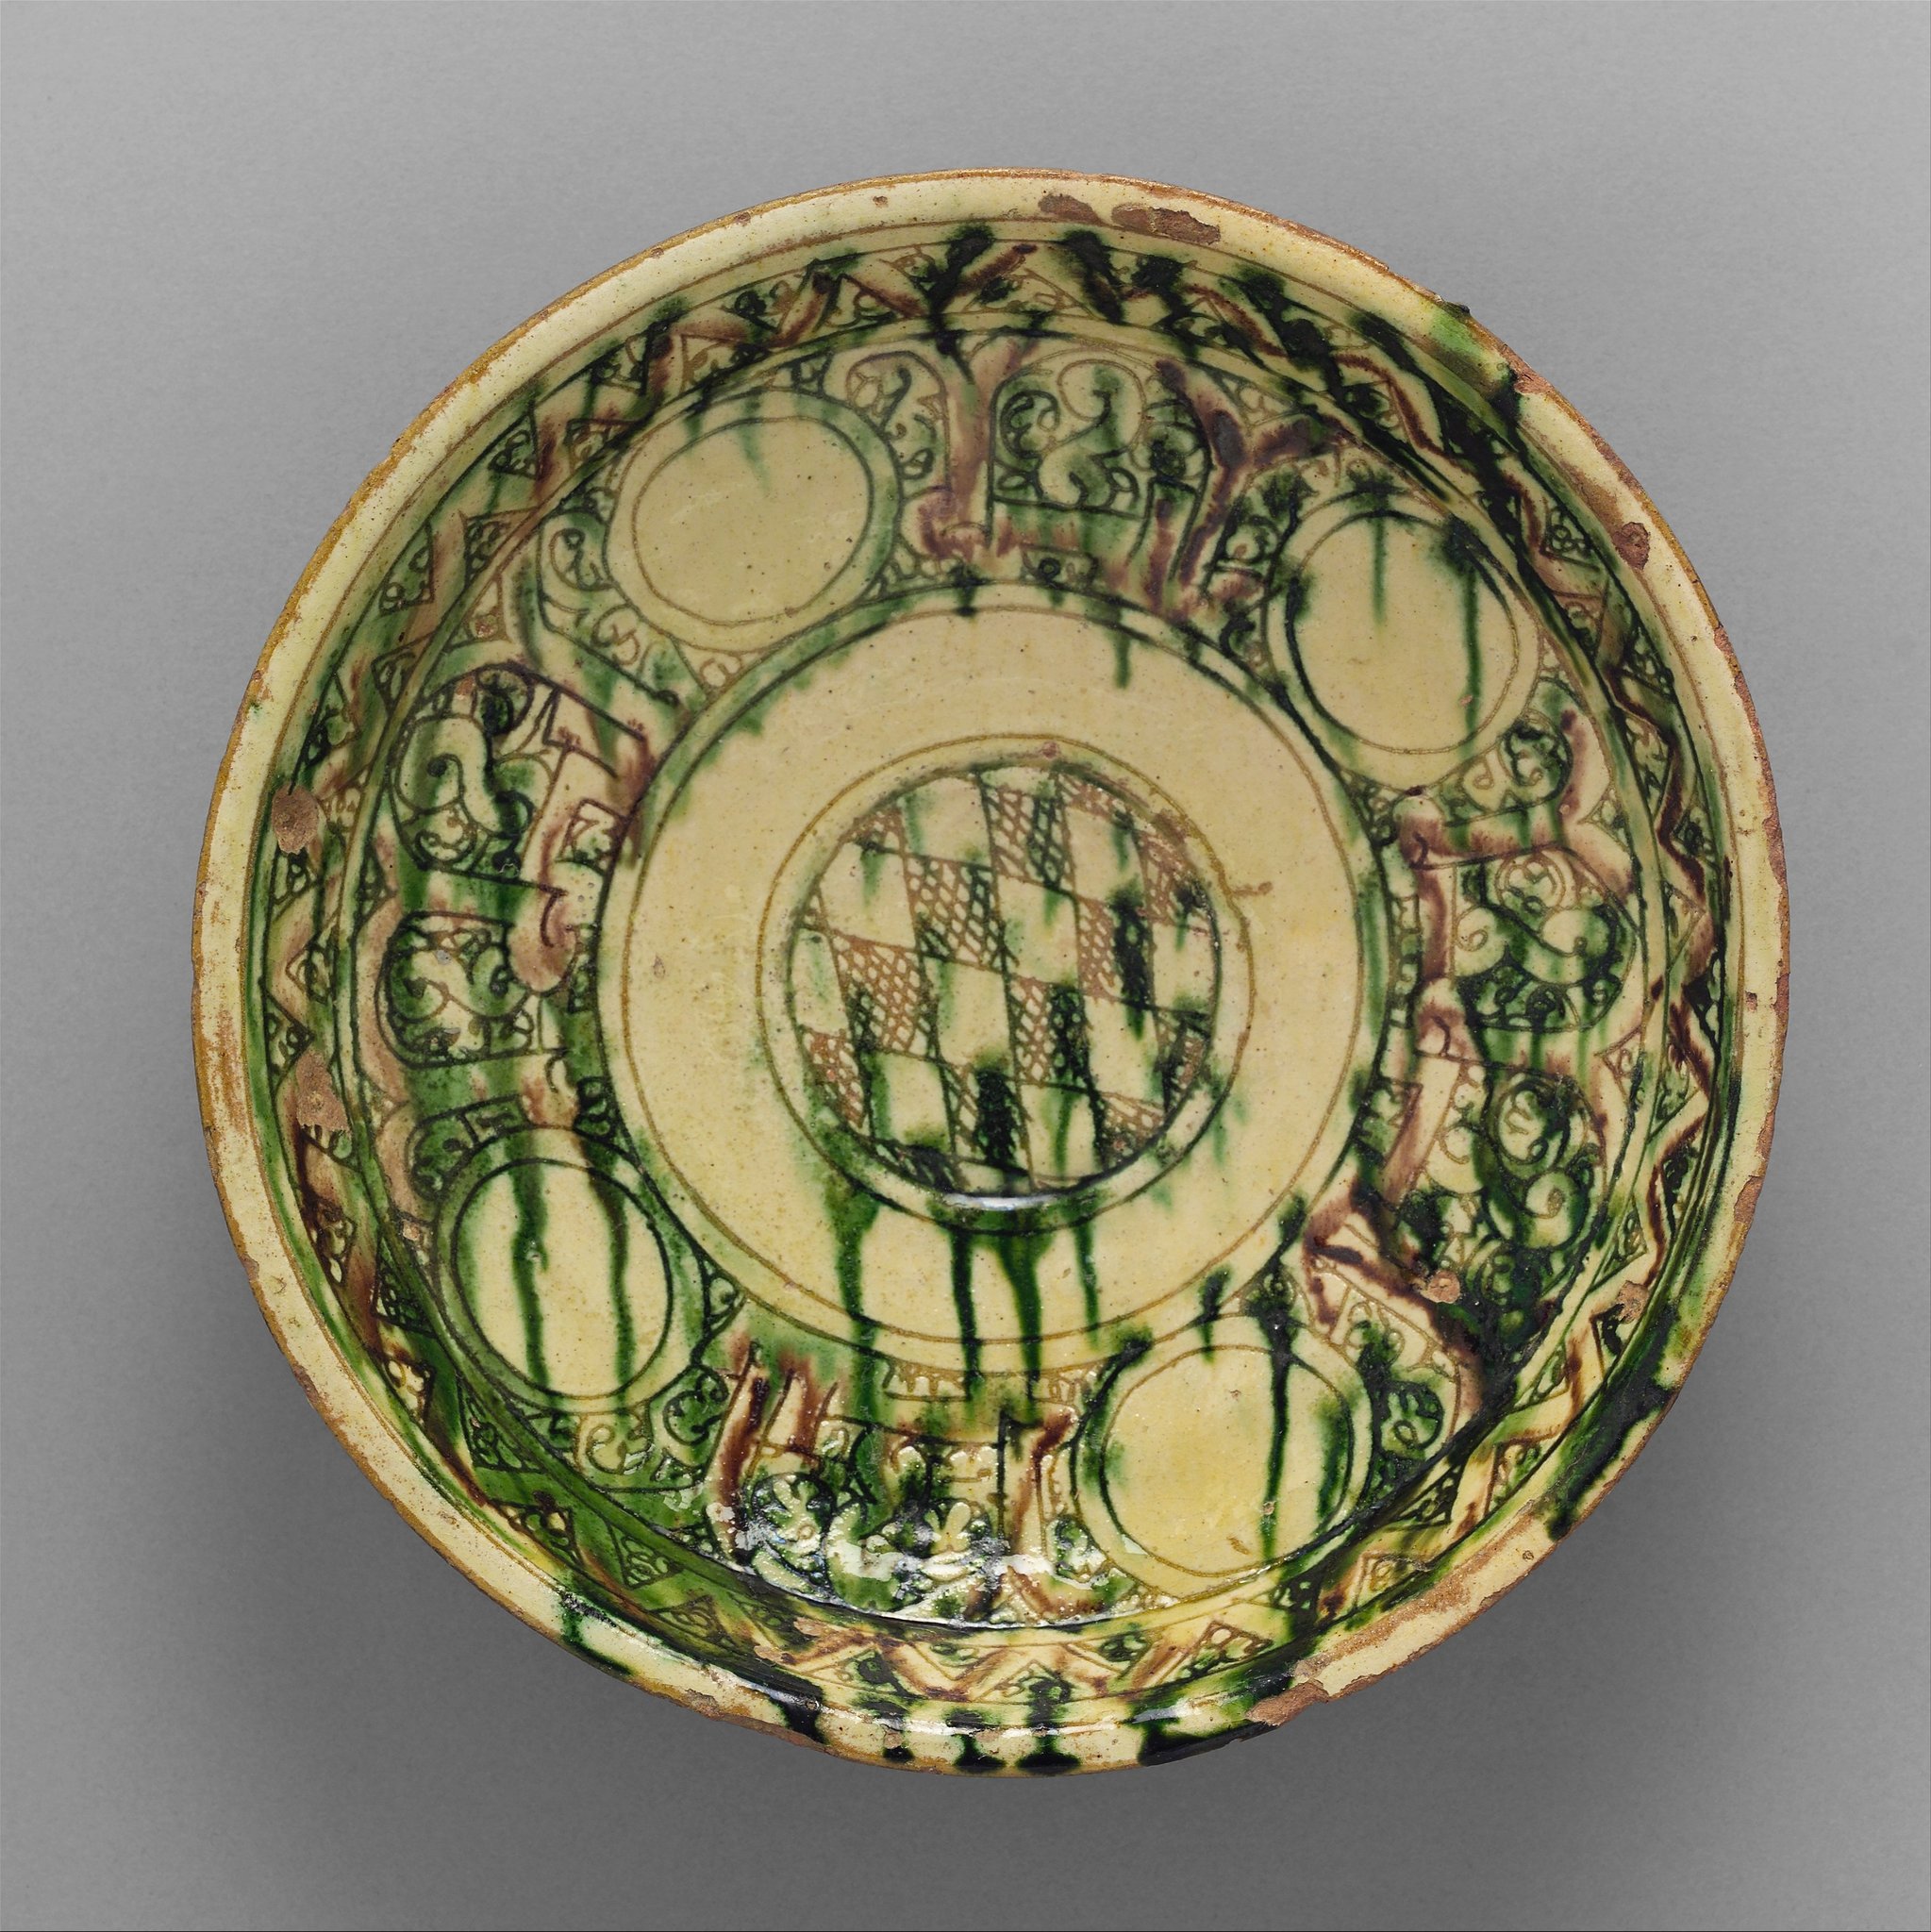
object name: plate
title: "Bamiyan Ware" bowl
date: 1001-1200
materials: earthenware, glaze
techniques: incising, polychrome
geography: central asia